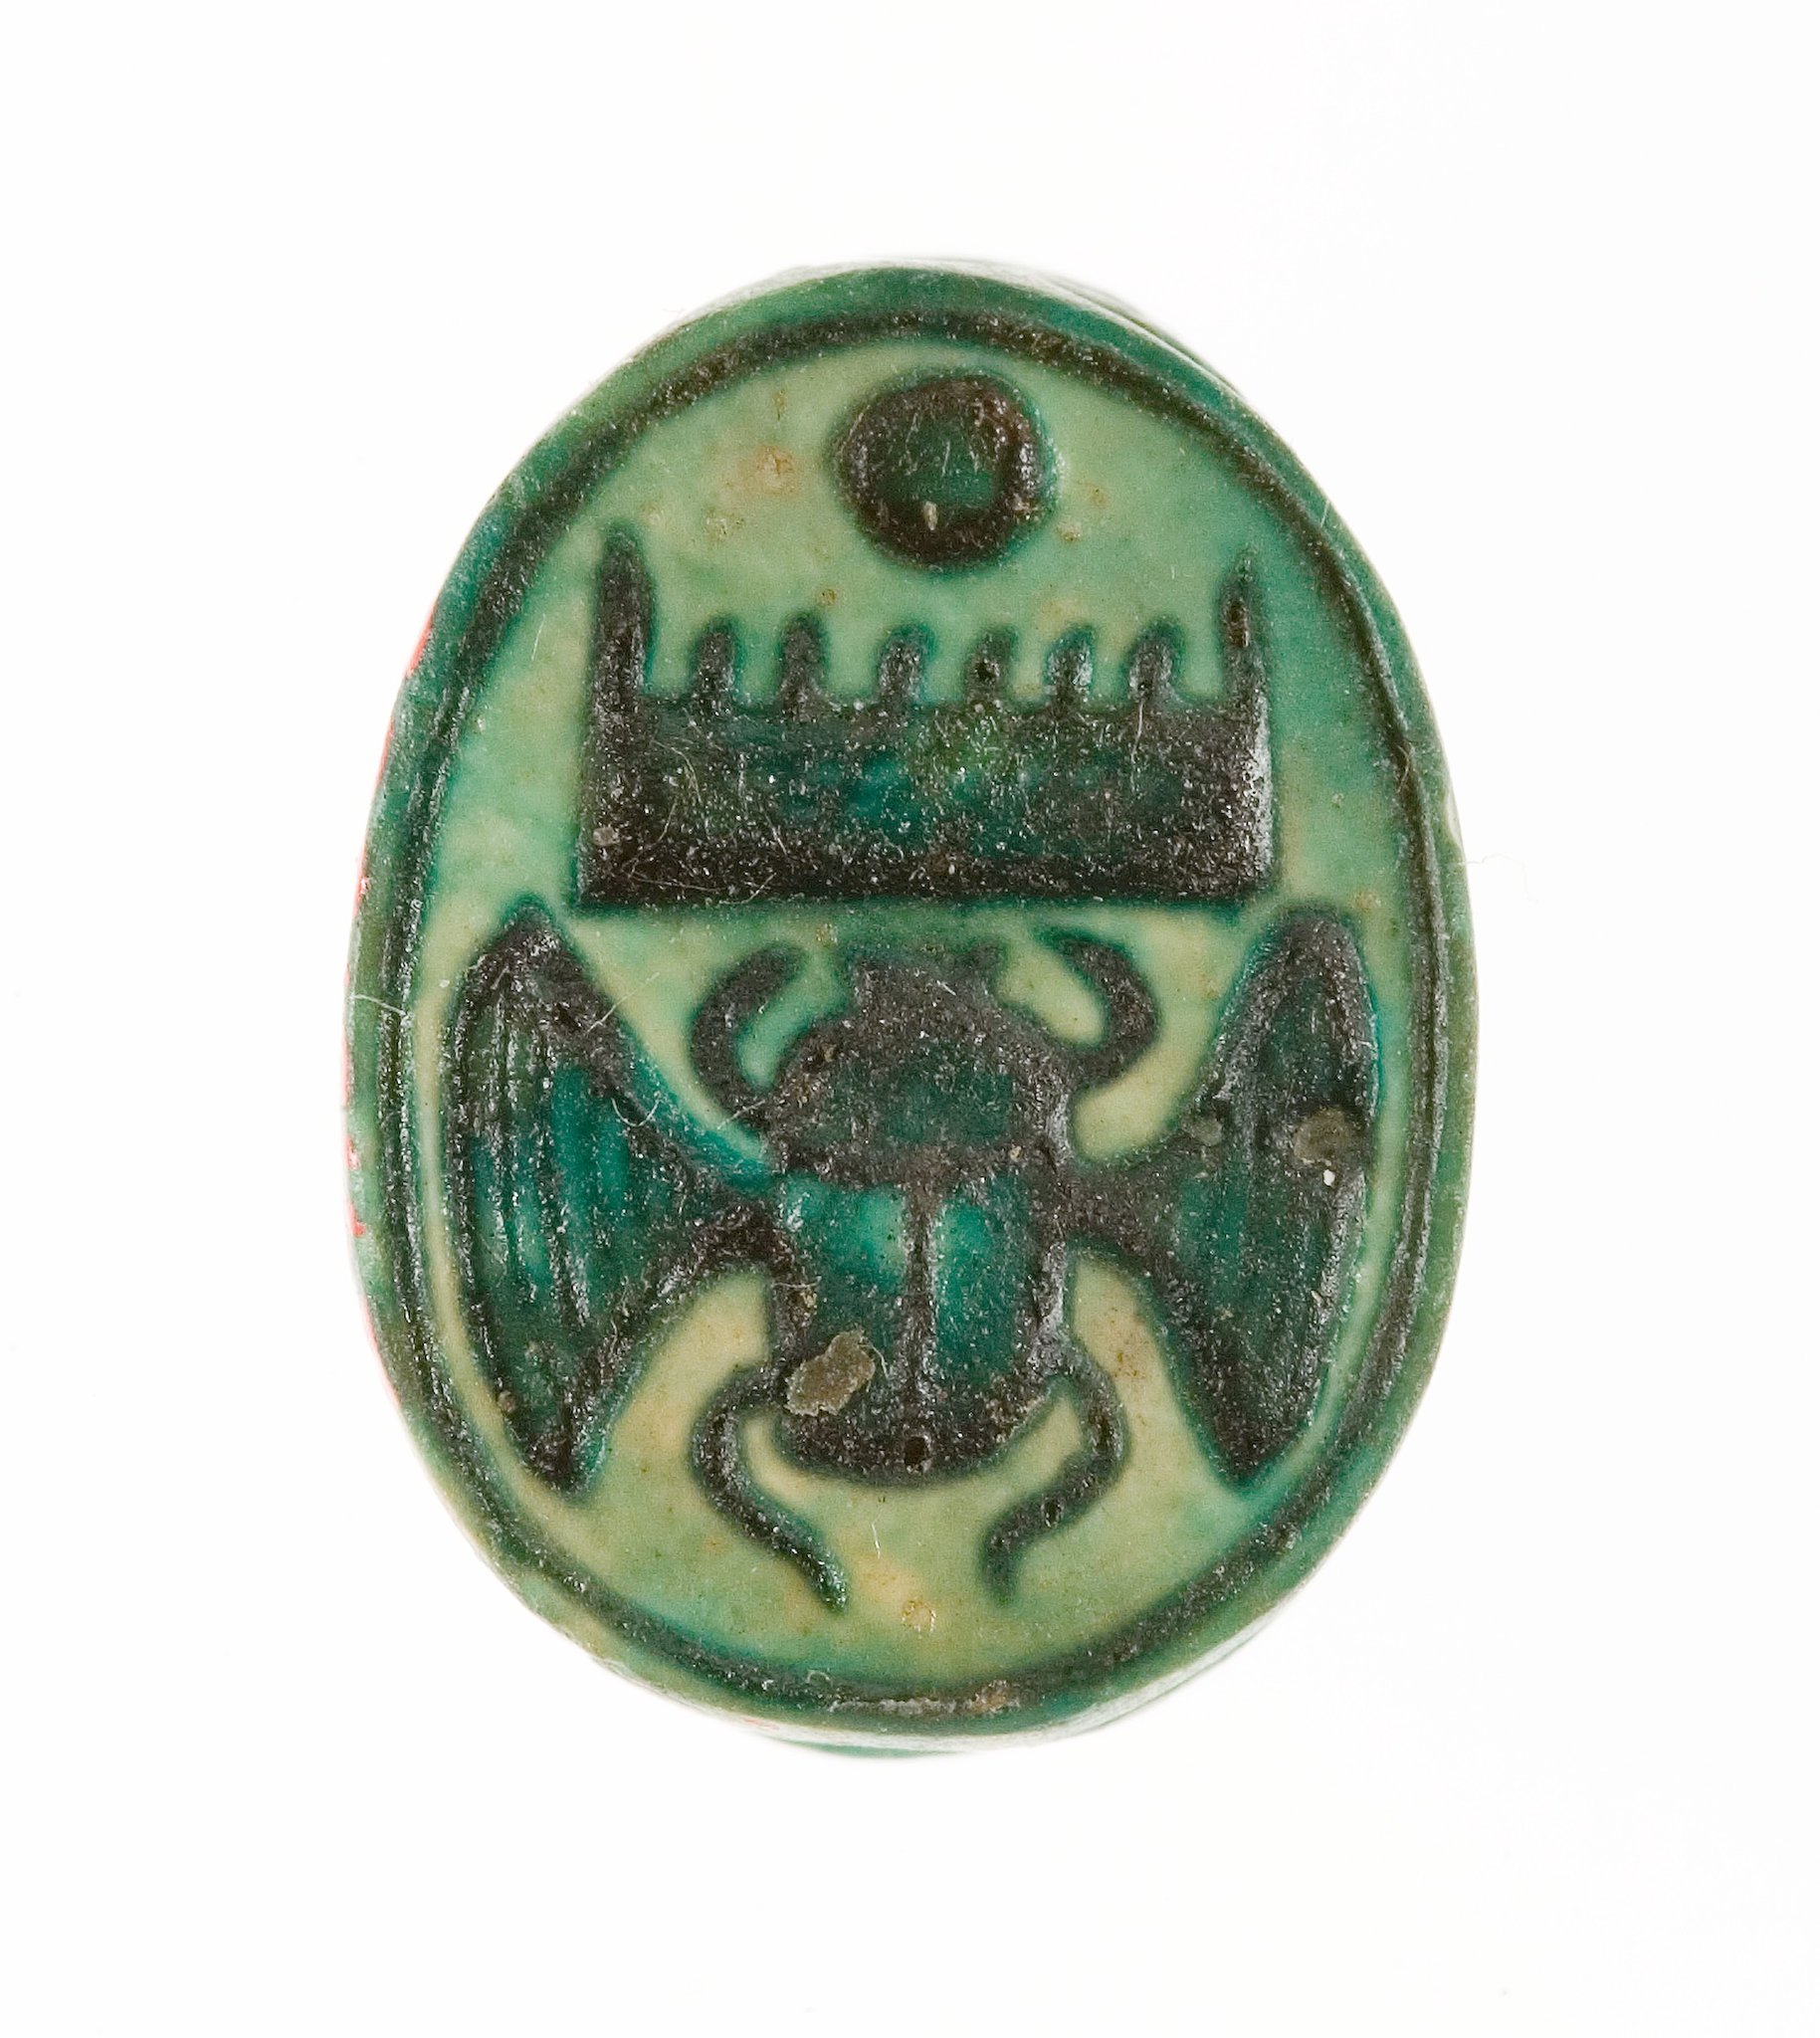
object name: scarab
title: Scarab Inscribed with the Throne Name of Thutmose III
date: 1479-1458 BCE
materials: stone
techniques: glazing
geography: egypt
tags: hieroglyphs,scarabs